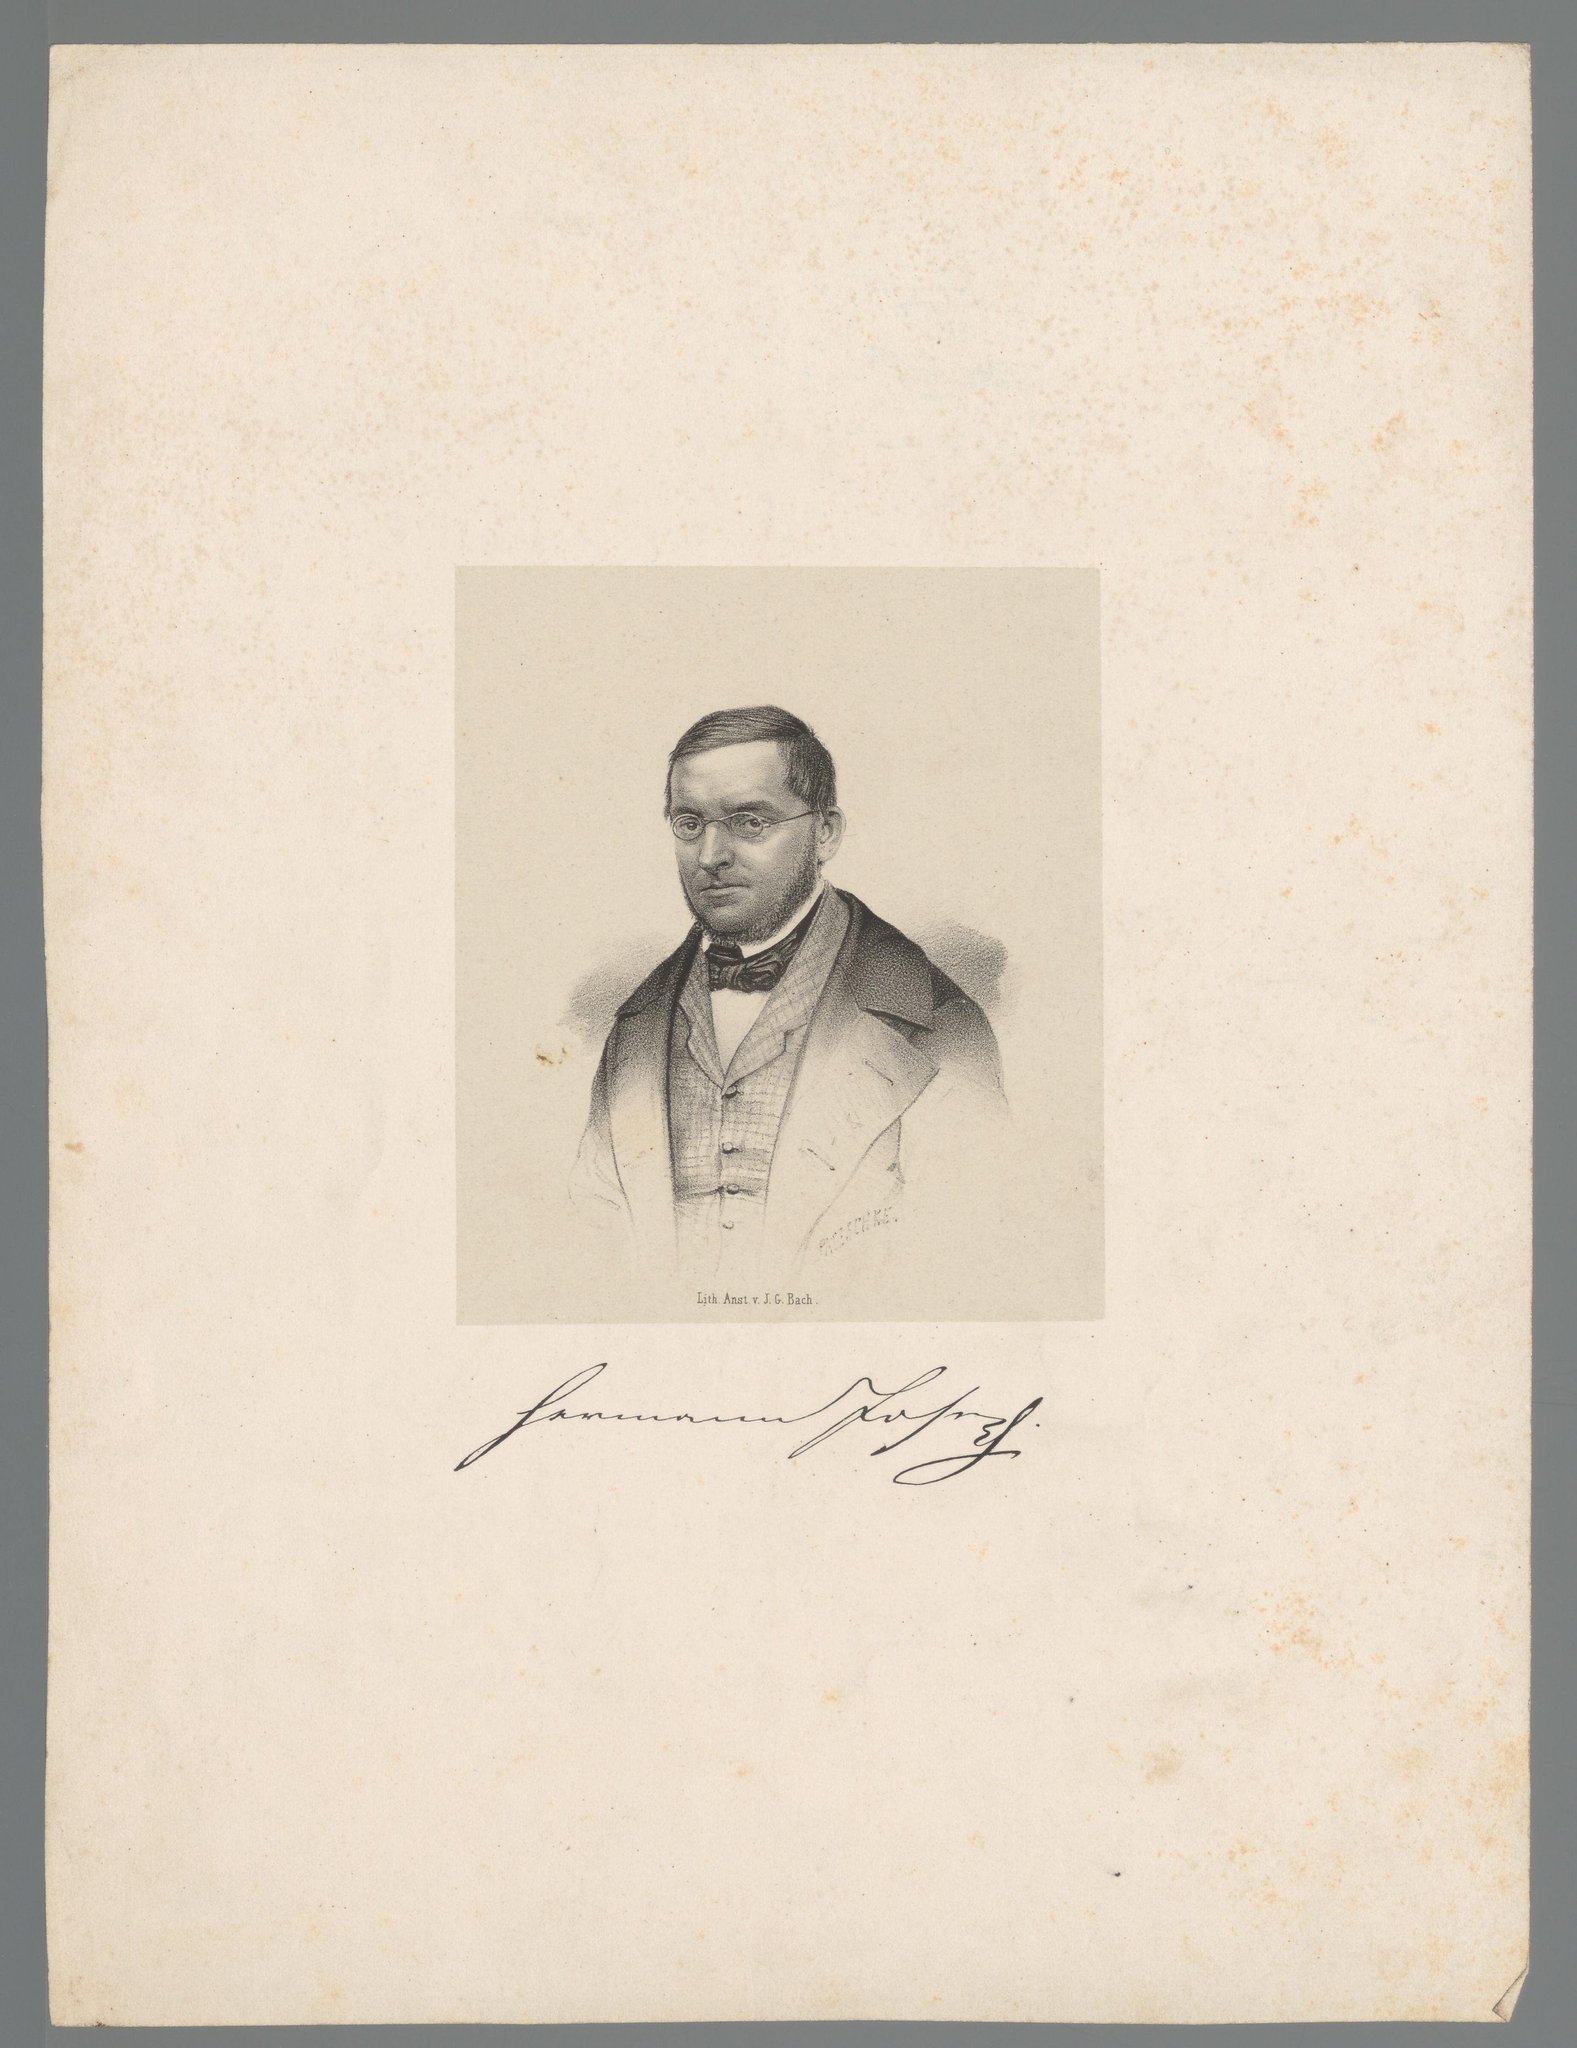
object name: print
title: Portret van een onbekende man, mogelijk Hermann Josef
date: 1823-1871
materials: paper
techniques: lithograph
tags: eyeglasses, spectacles, adult man, historical persons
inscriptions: collector's mark: Lugt 2228